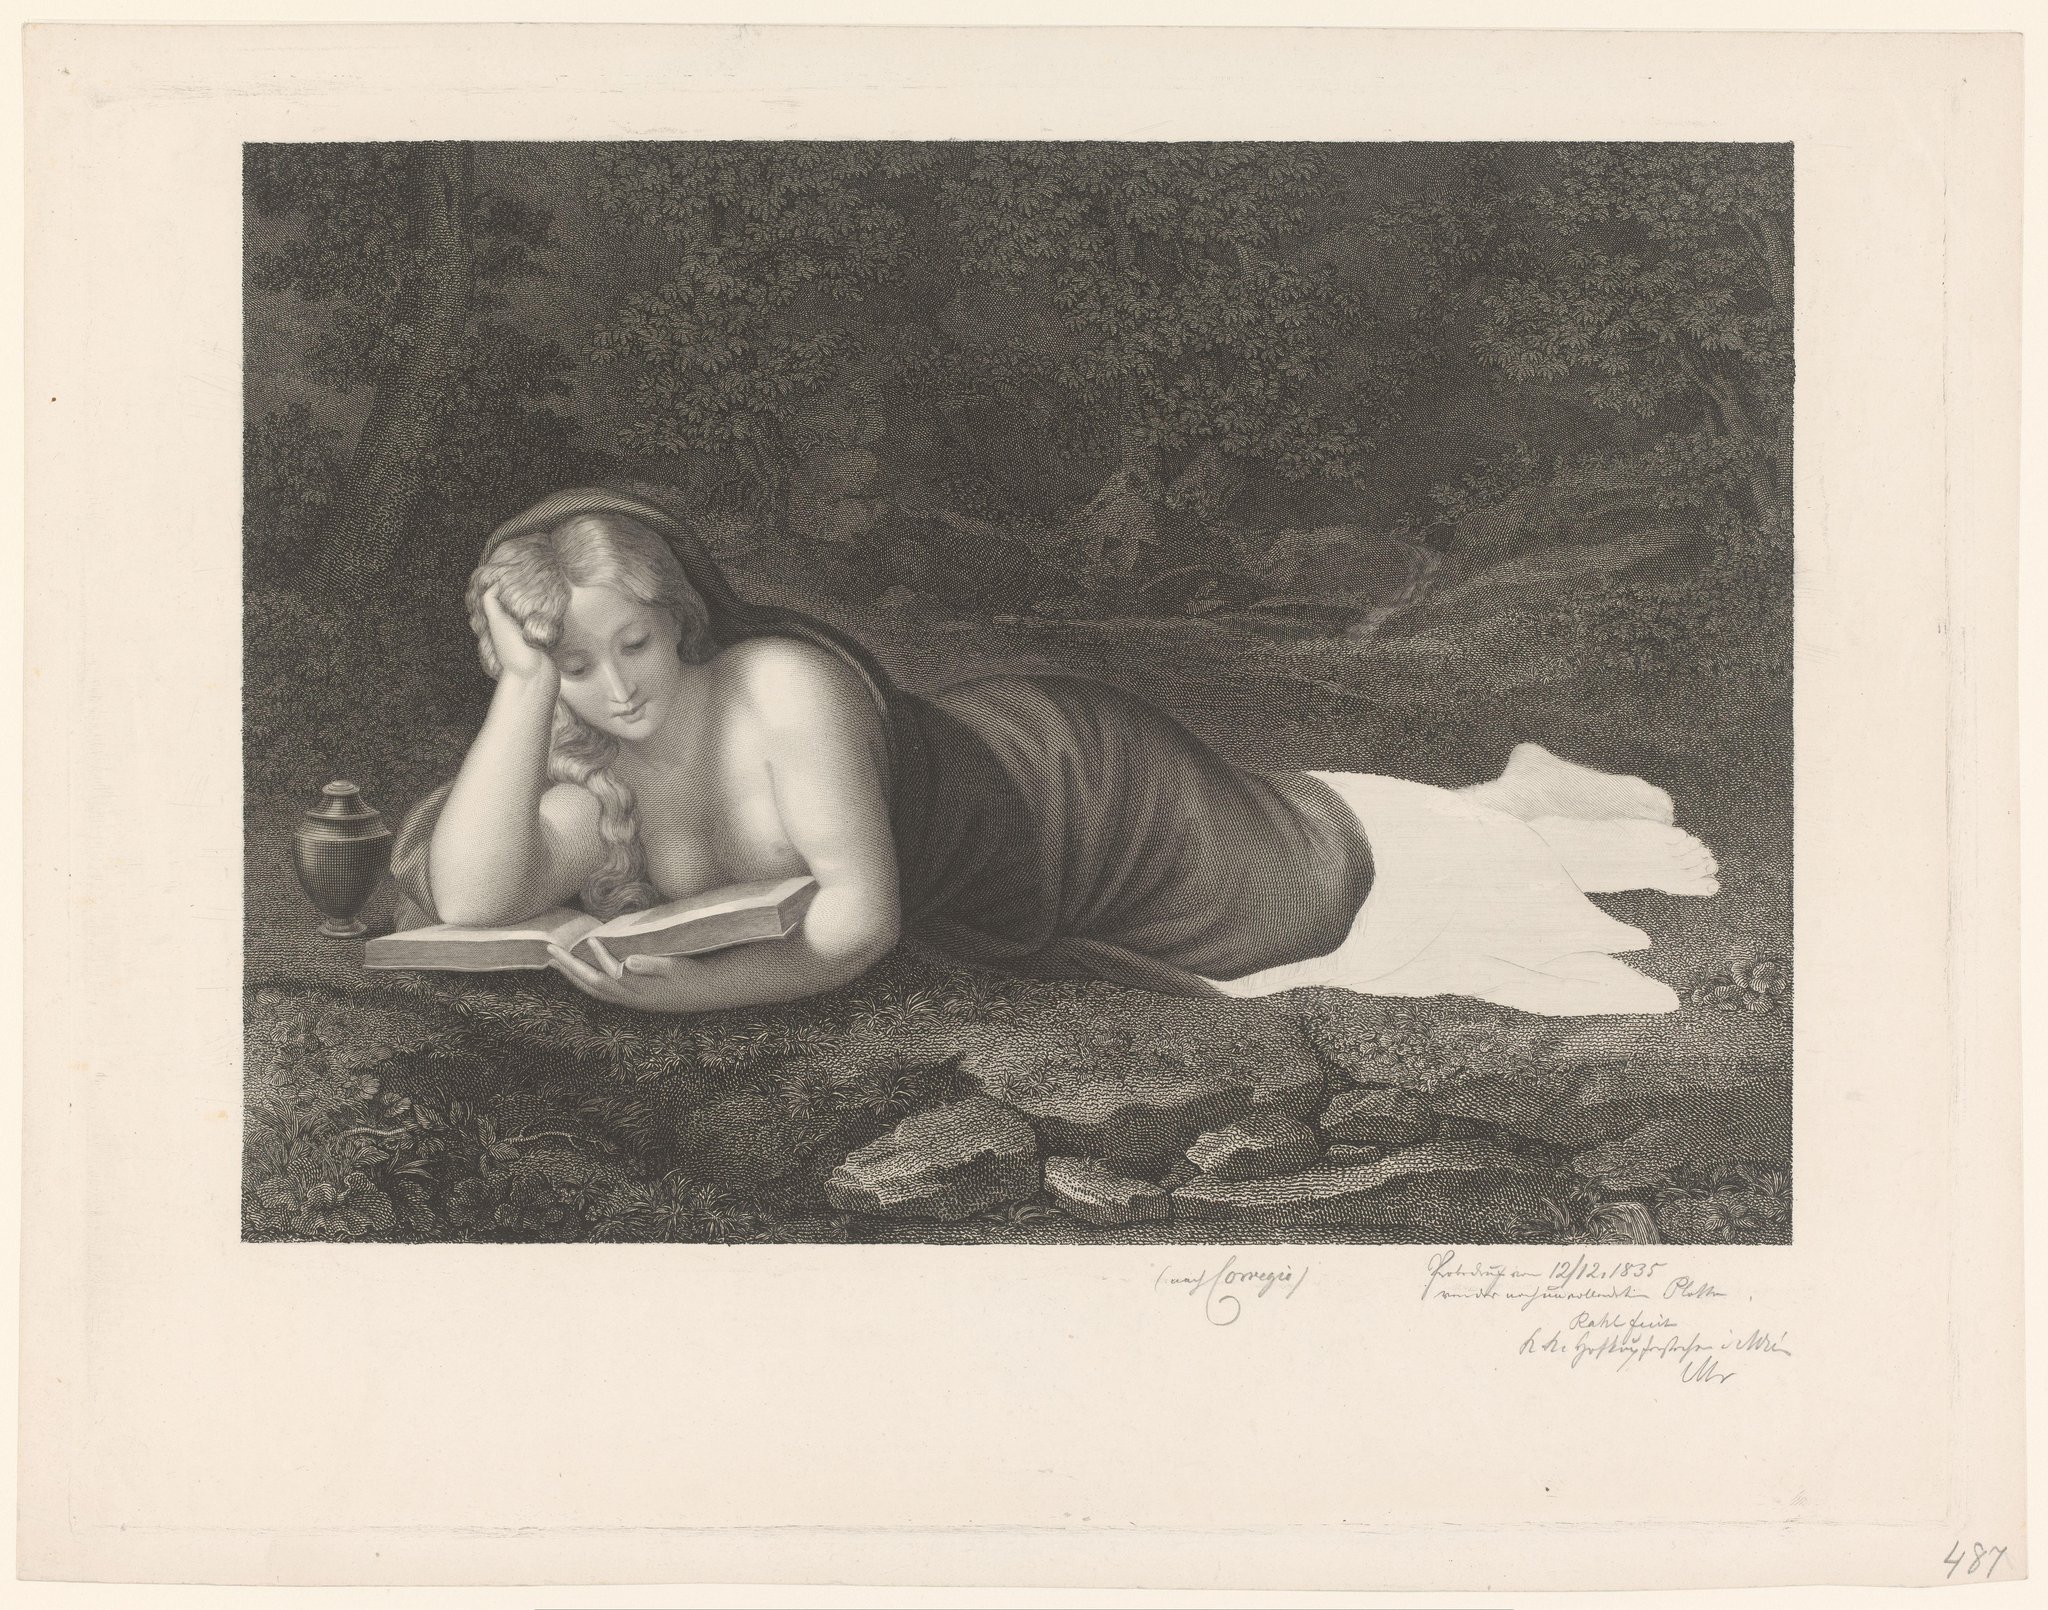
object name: print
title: Lezende Maria Magdalena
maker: carl rahl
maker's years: 1812-1865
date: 1826-1827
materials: paper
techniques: engraving, etching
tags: reading, the penitent harlot mary magdalene; possible attributes: book (or scroll), crown, crown of thorns, crucifix, jar of ointment, mirror, musical instrument, palm-branch, rosary, scourge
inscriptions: inscription: ‘(nach Corregio)’, inscription: ‘Probedrück ovn 12/12,1835/ [...] Platze (?)/ Rahl fecit/ h hc Goltrüy (?) [...]/ Mr’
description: De lezende Maria Magdalena ligt op de grond met voor haar de zalfpot.